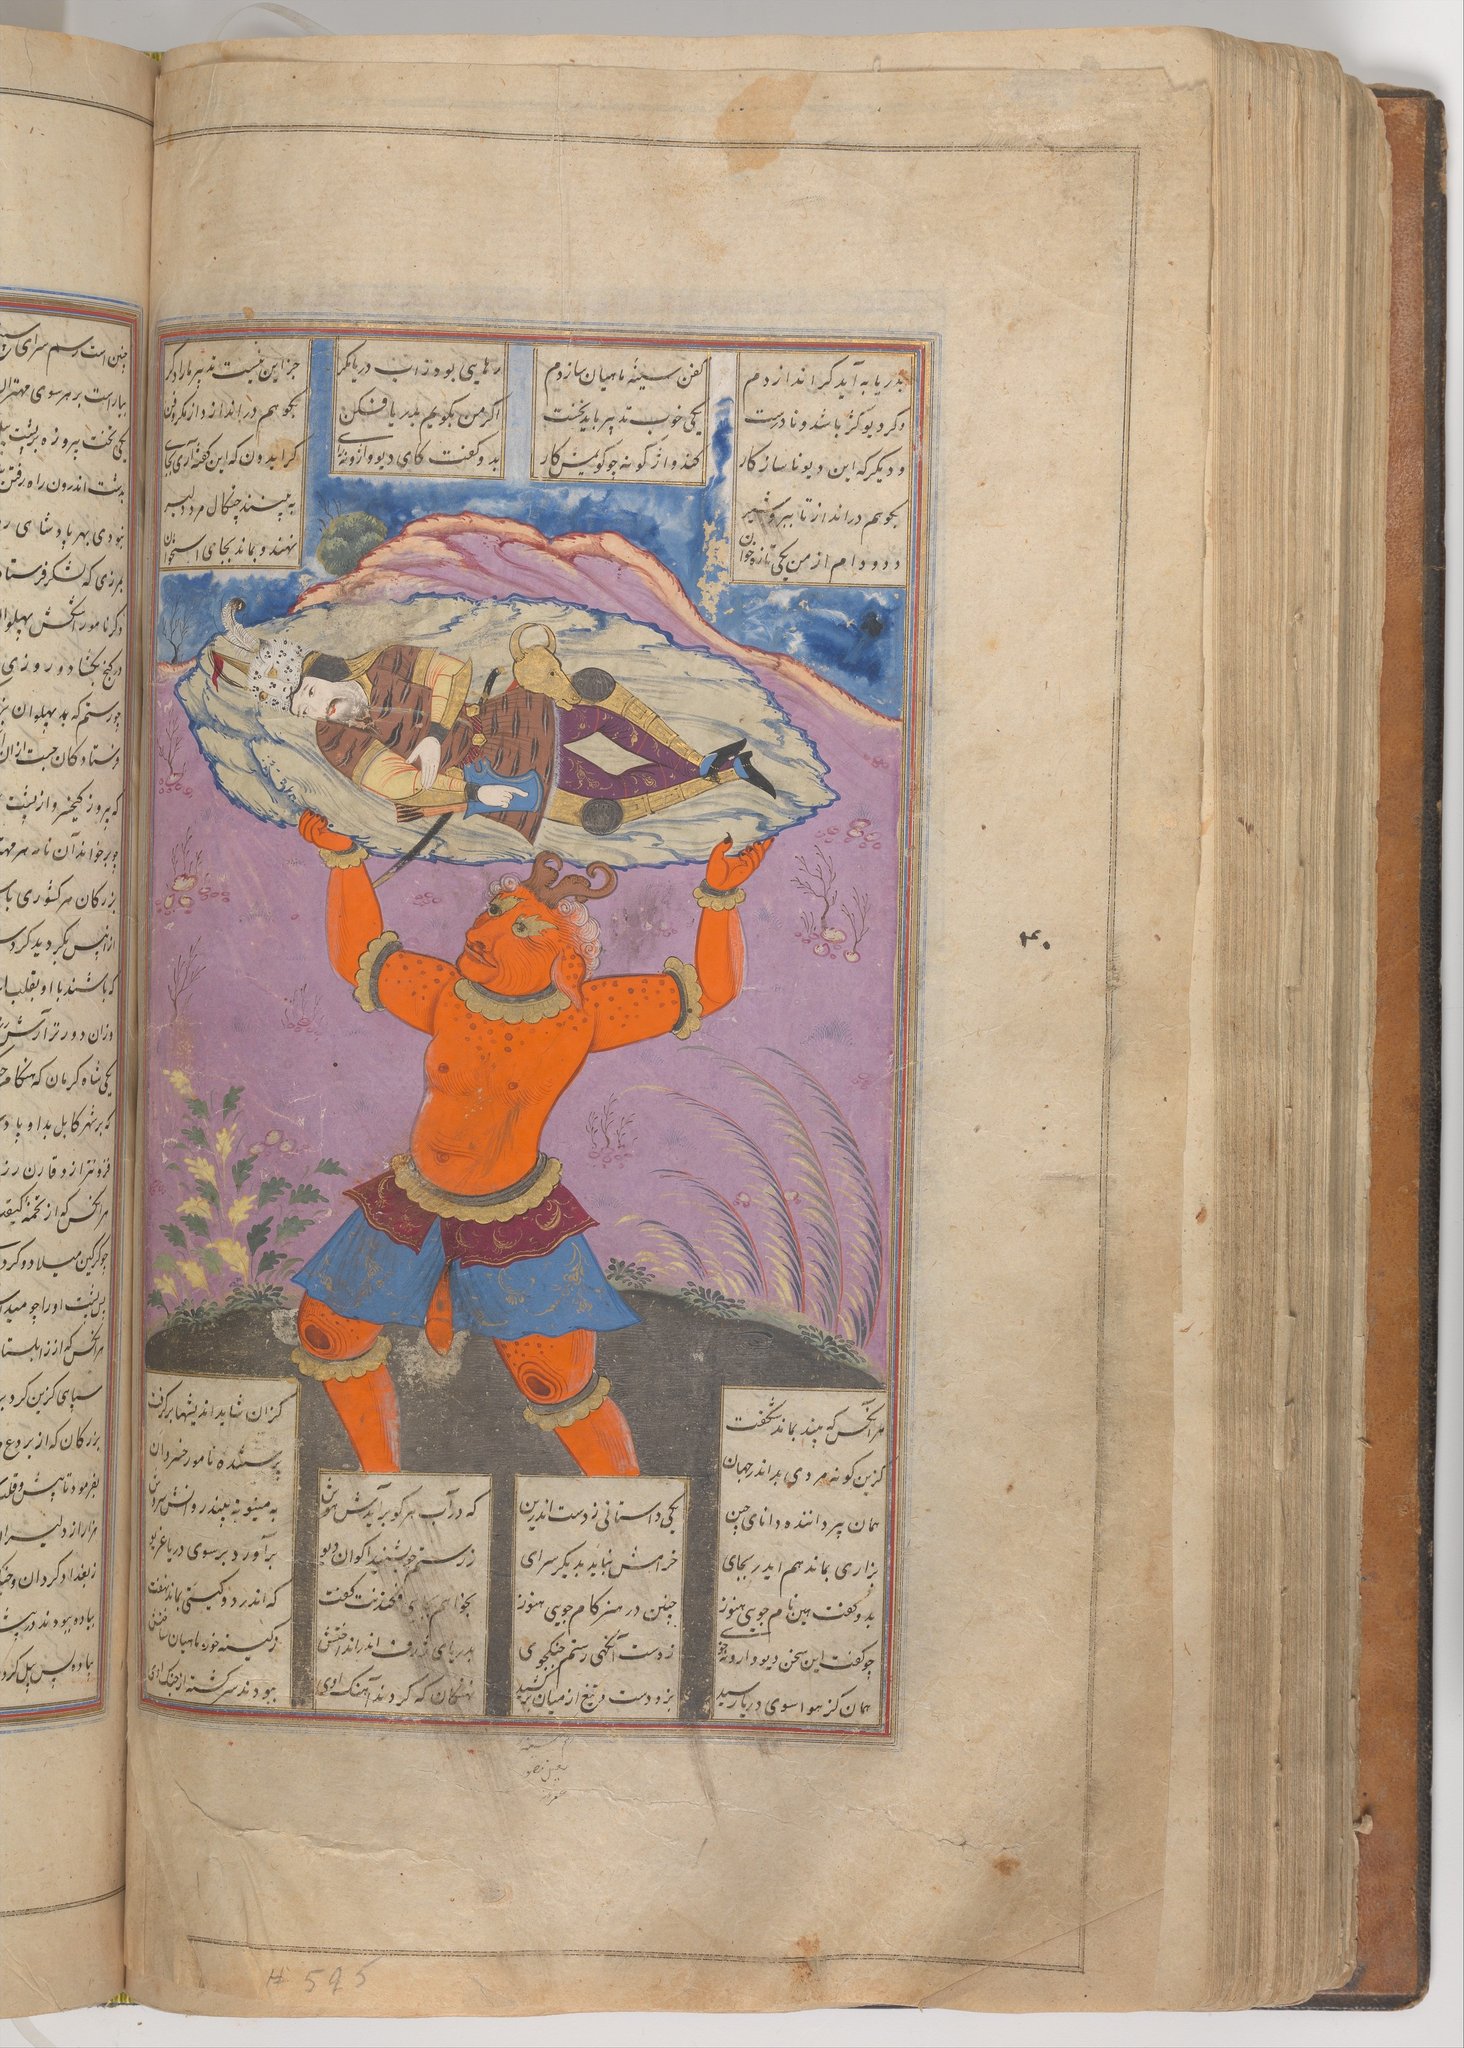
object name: illustrated manuscript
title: Shahnama (Book of Kings) of Firdausi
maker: mu'in musavvir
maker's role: artist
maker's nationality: iranian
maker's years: 1605-1722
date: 1660-1669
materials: gold, ink, paper, silver, watercolor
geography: iran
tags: men,horses,lions,demons,wolves